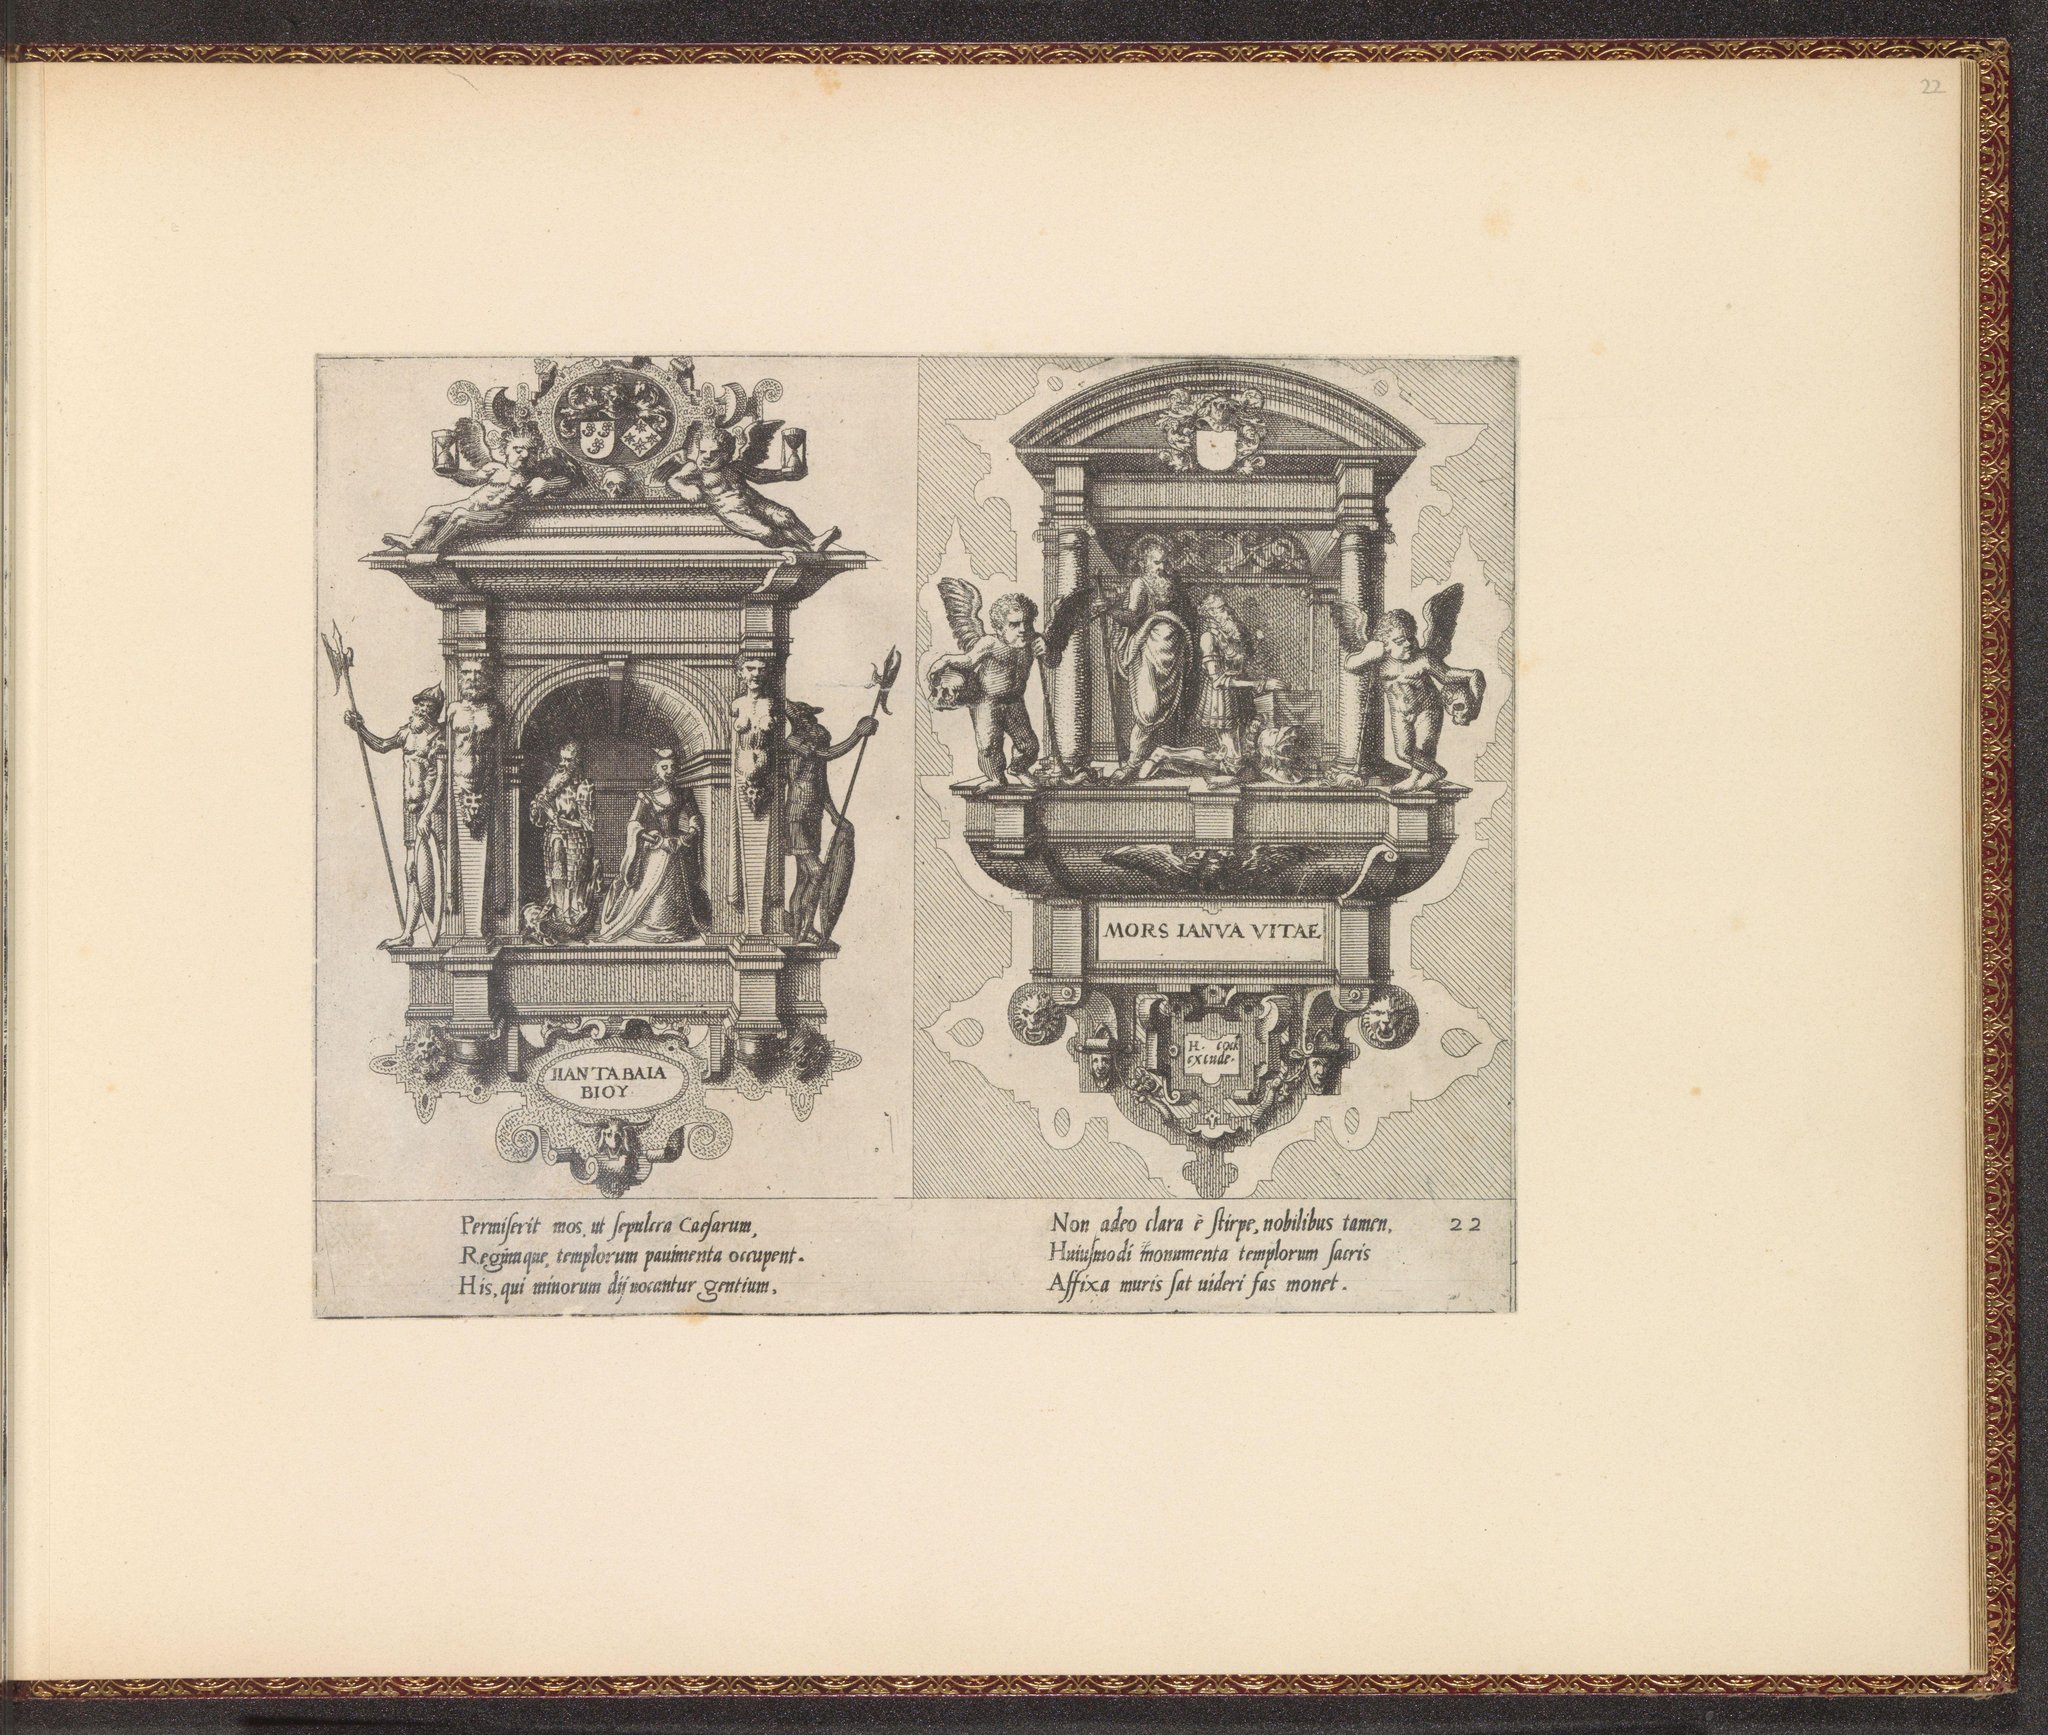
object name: album leaf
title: Twee epitafen met knielende figuren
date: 1563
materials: paper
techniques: etching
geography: antwerp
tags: kneeling figure, grave-building, monumental tomb, grave, tomb and other grave-forms and grave-markers, epitaph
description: Twee epitafen of grafmonumenten die tegen een wand geplaatst moeten worden. De epitaaf links toont een knielend koppel. Daarboven twee engelen met een zandloper. Het monument rechts heeft een knielende man met naast hem zijn patroonheilige Paulus. Daarbij twee engelen met loftrompet en doodshoofd. In de ondermarge zes regels tekst, in twee kolommen, in het Latijn. De prent maakt deel uit van een album.